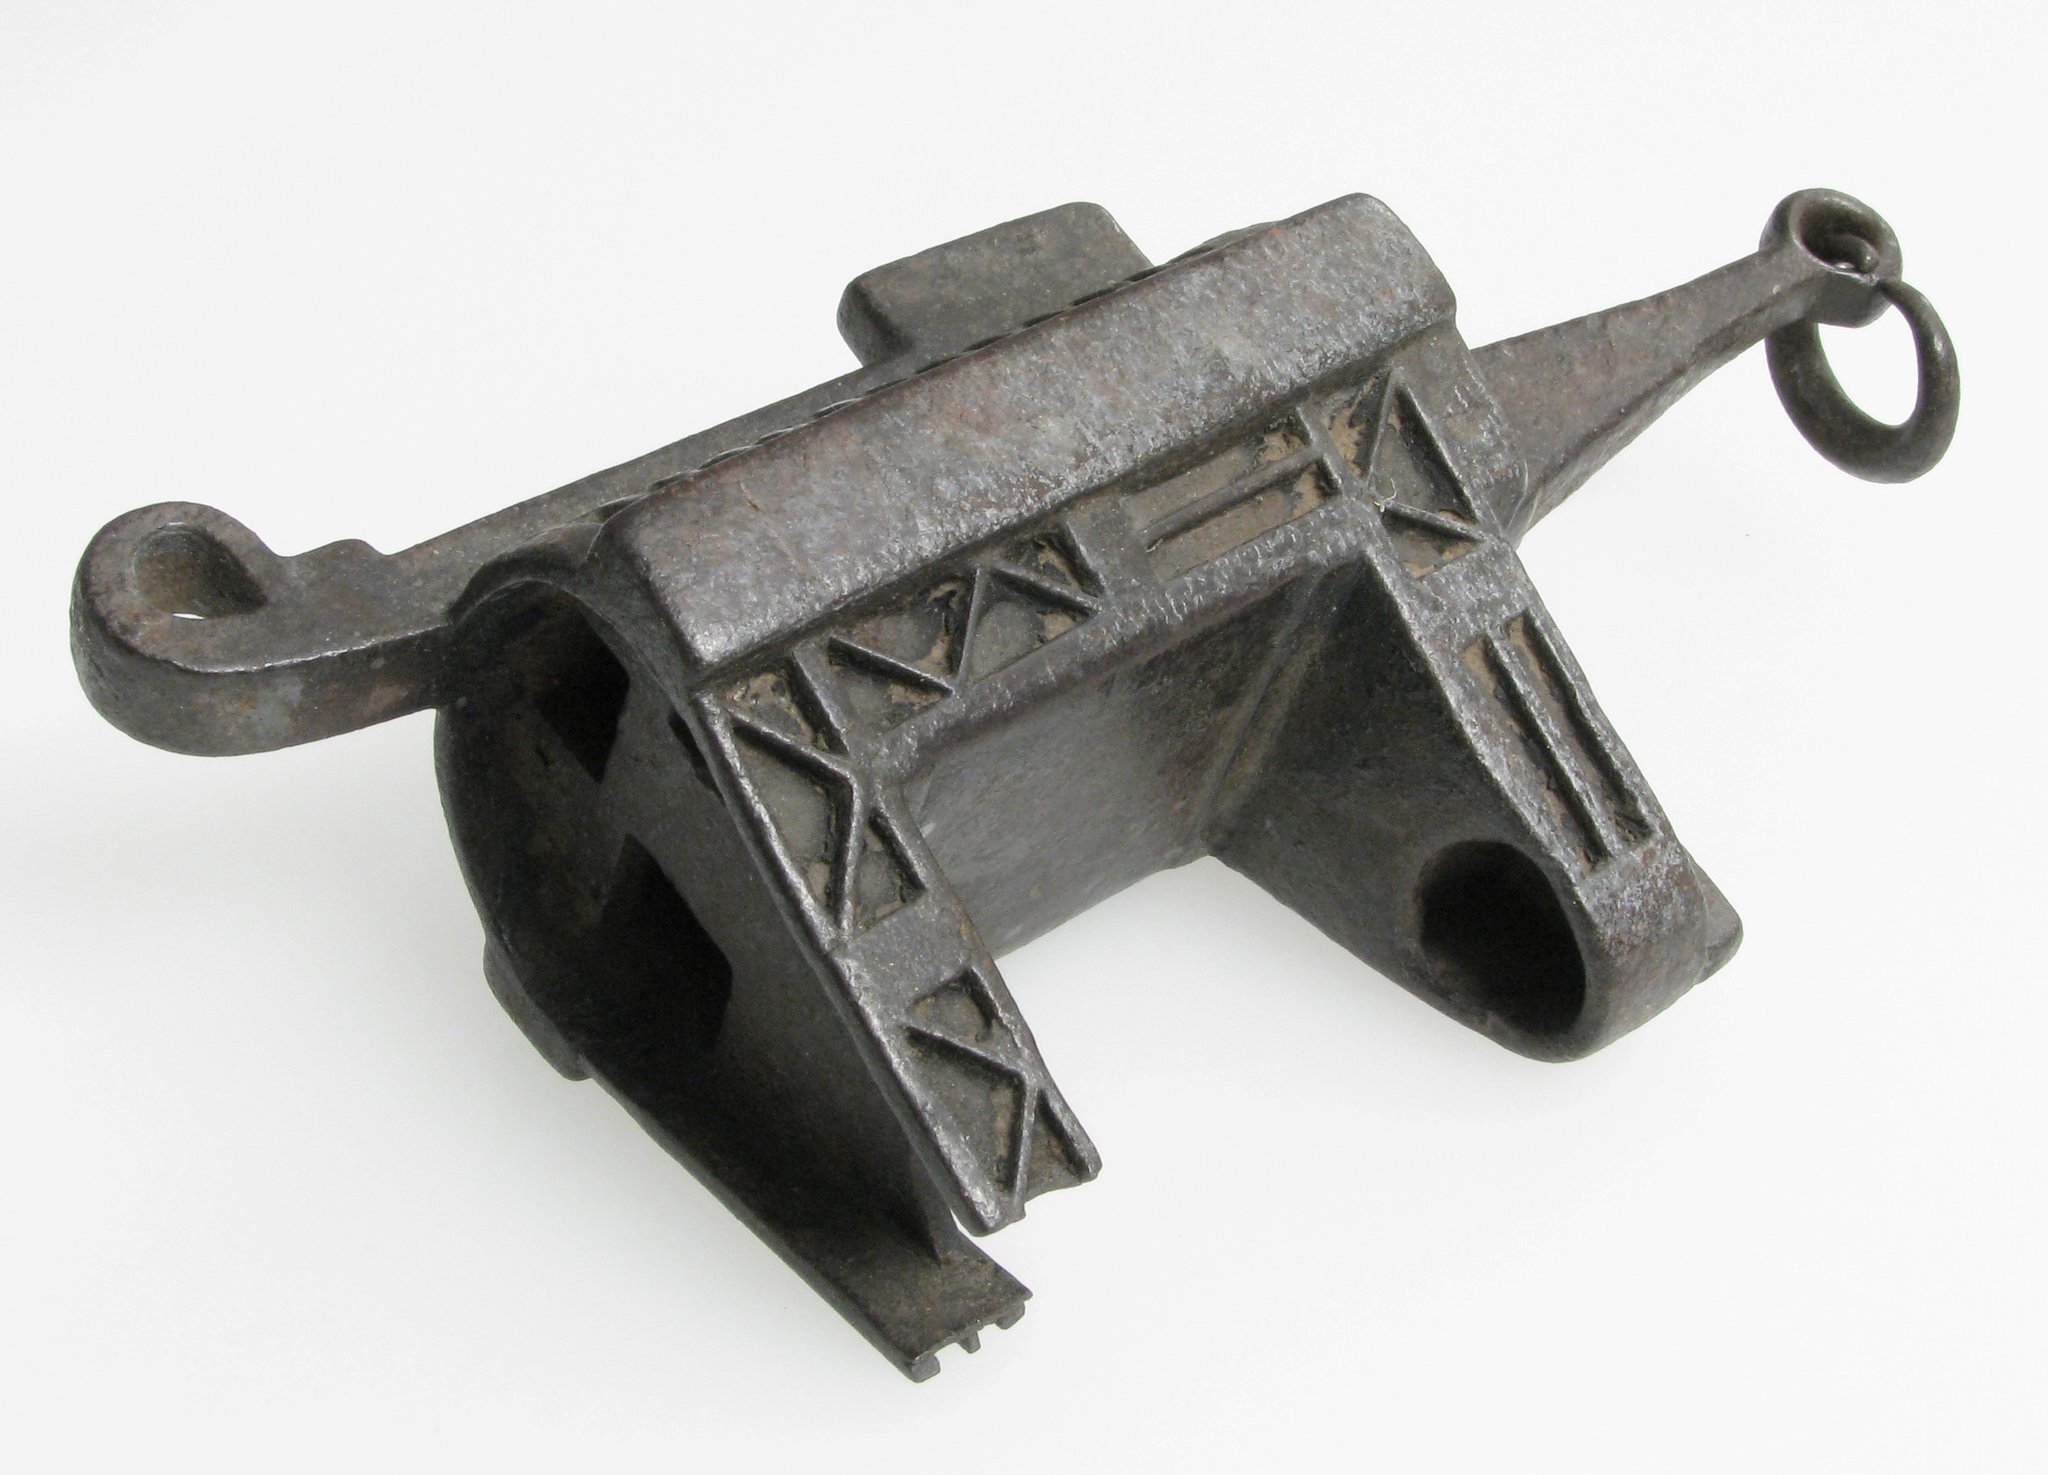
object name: padlock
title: Part of a Padlock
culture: european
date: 1301-1500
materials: iron